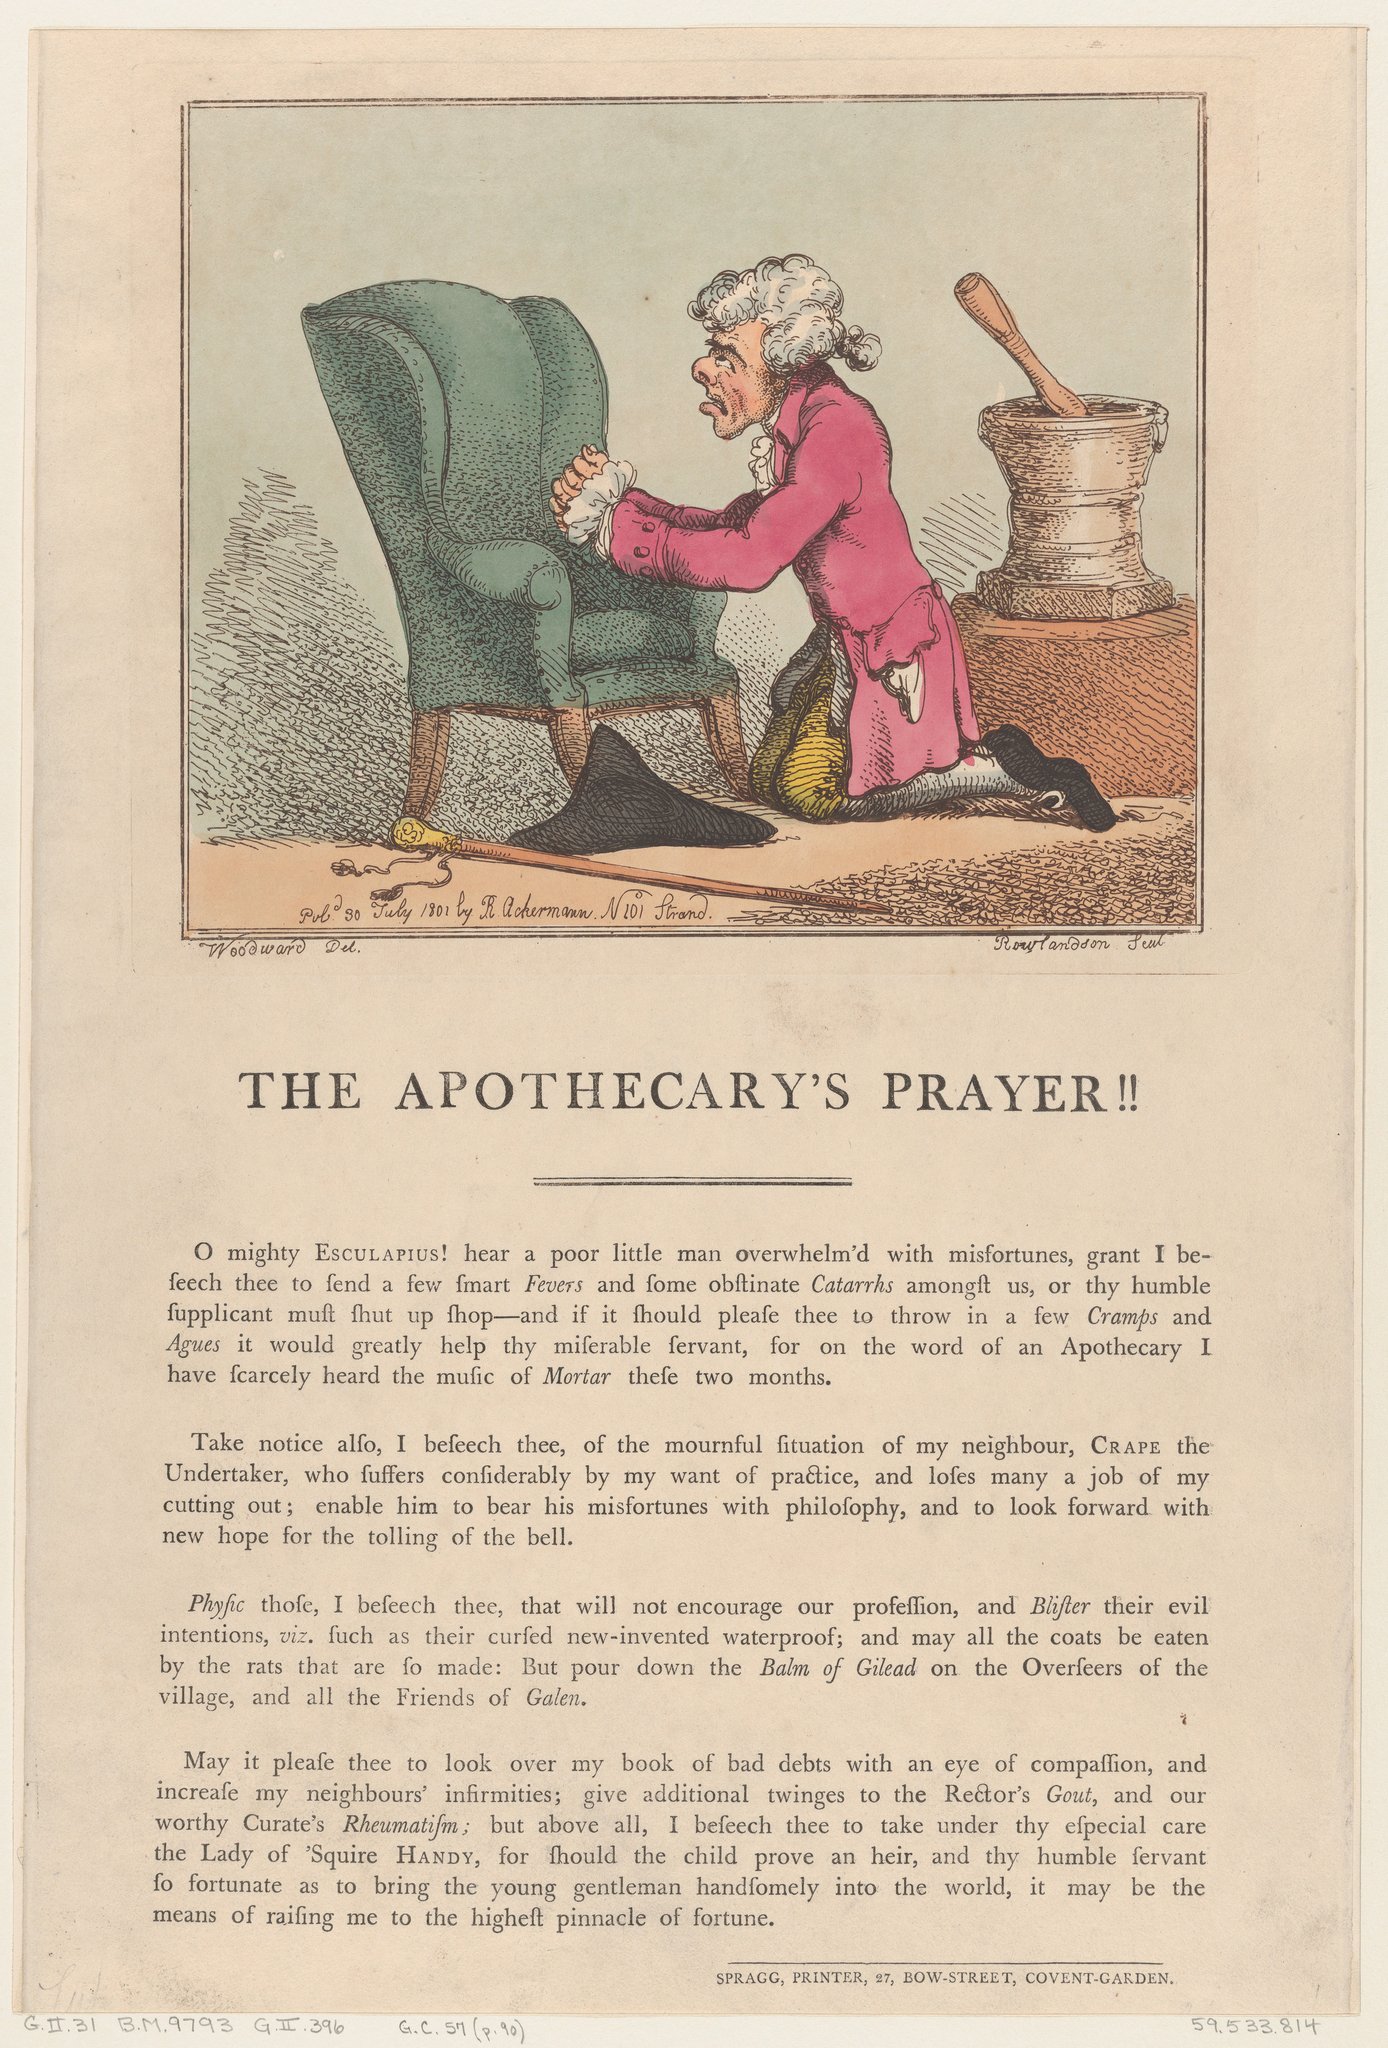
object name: print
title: The Apothecary's Prayer!!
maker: thomas rowlandson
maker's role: artist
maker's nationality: british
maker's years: 1757-1827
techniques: etching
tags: men,chairs